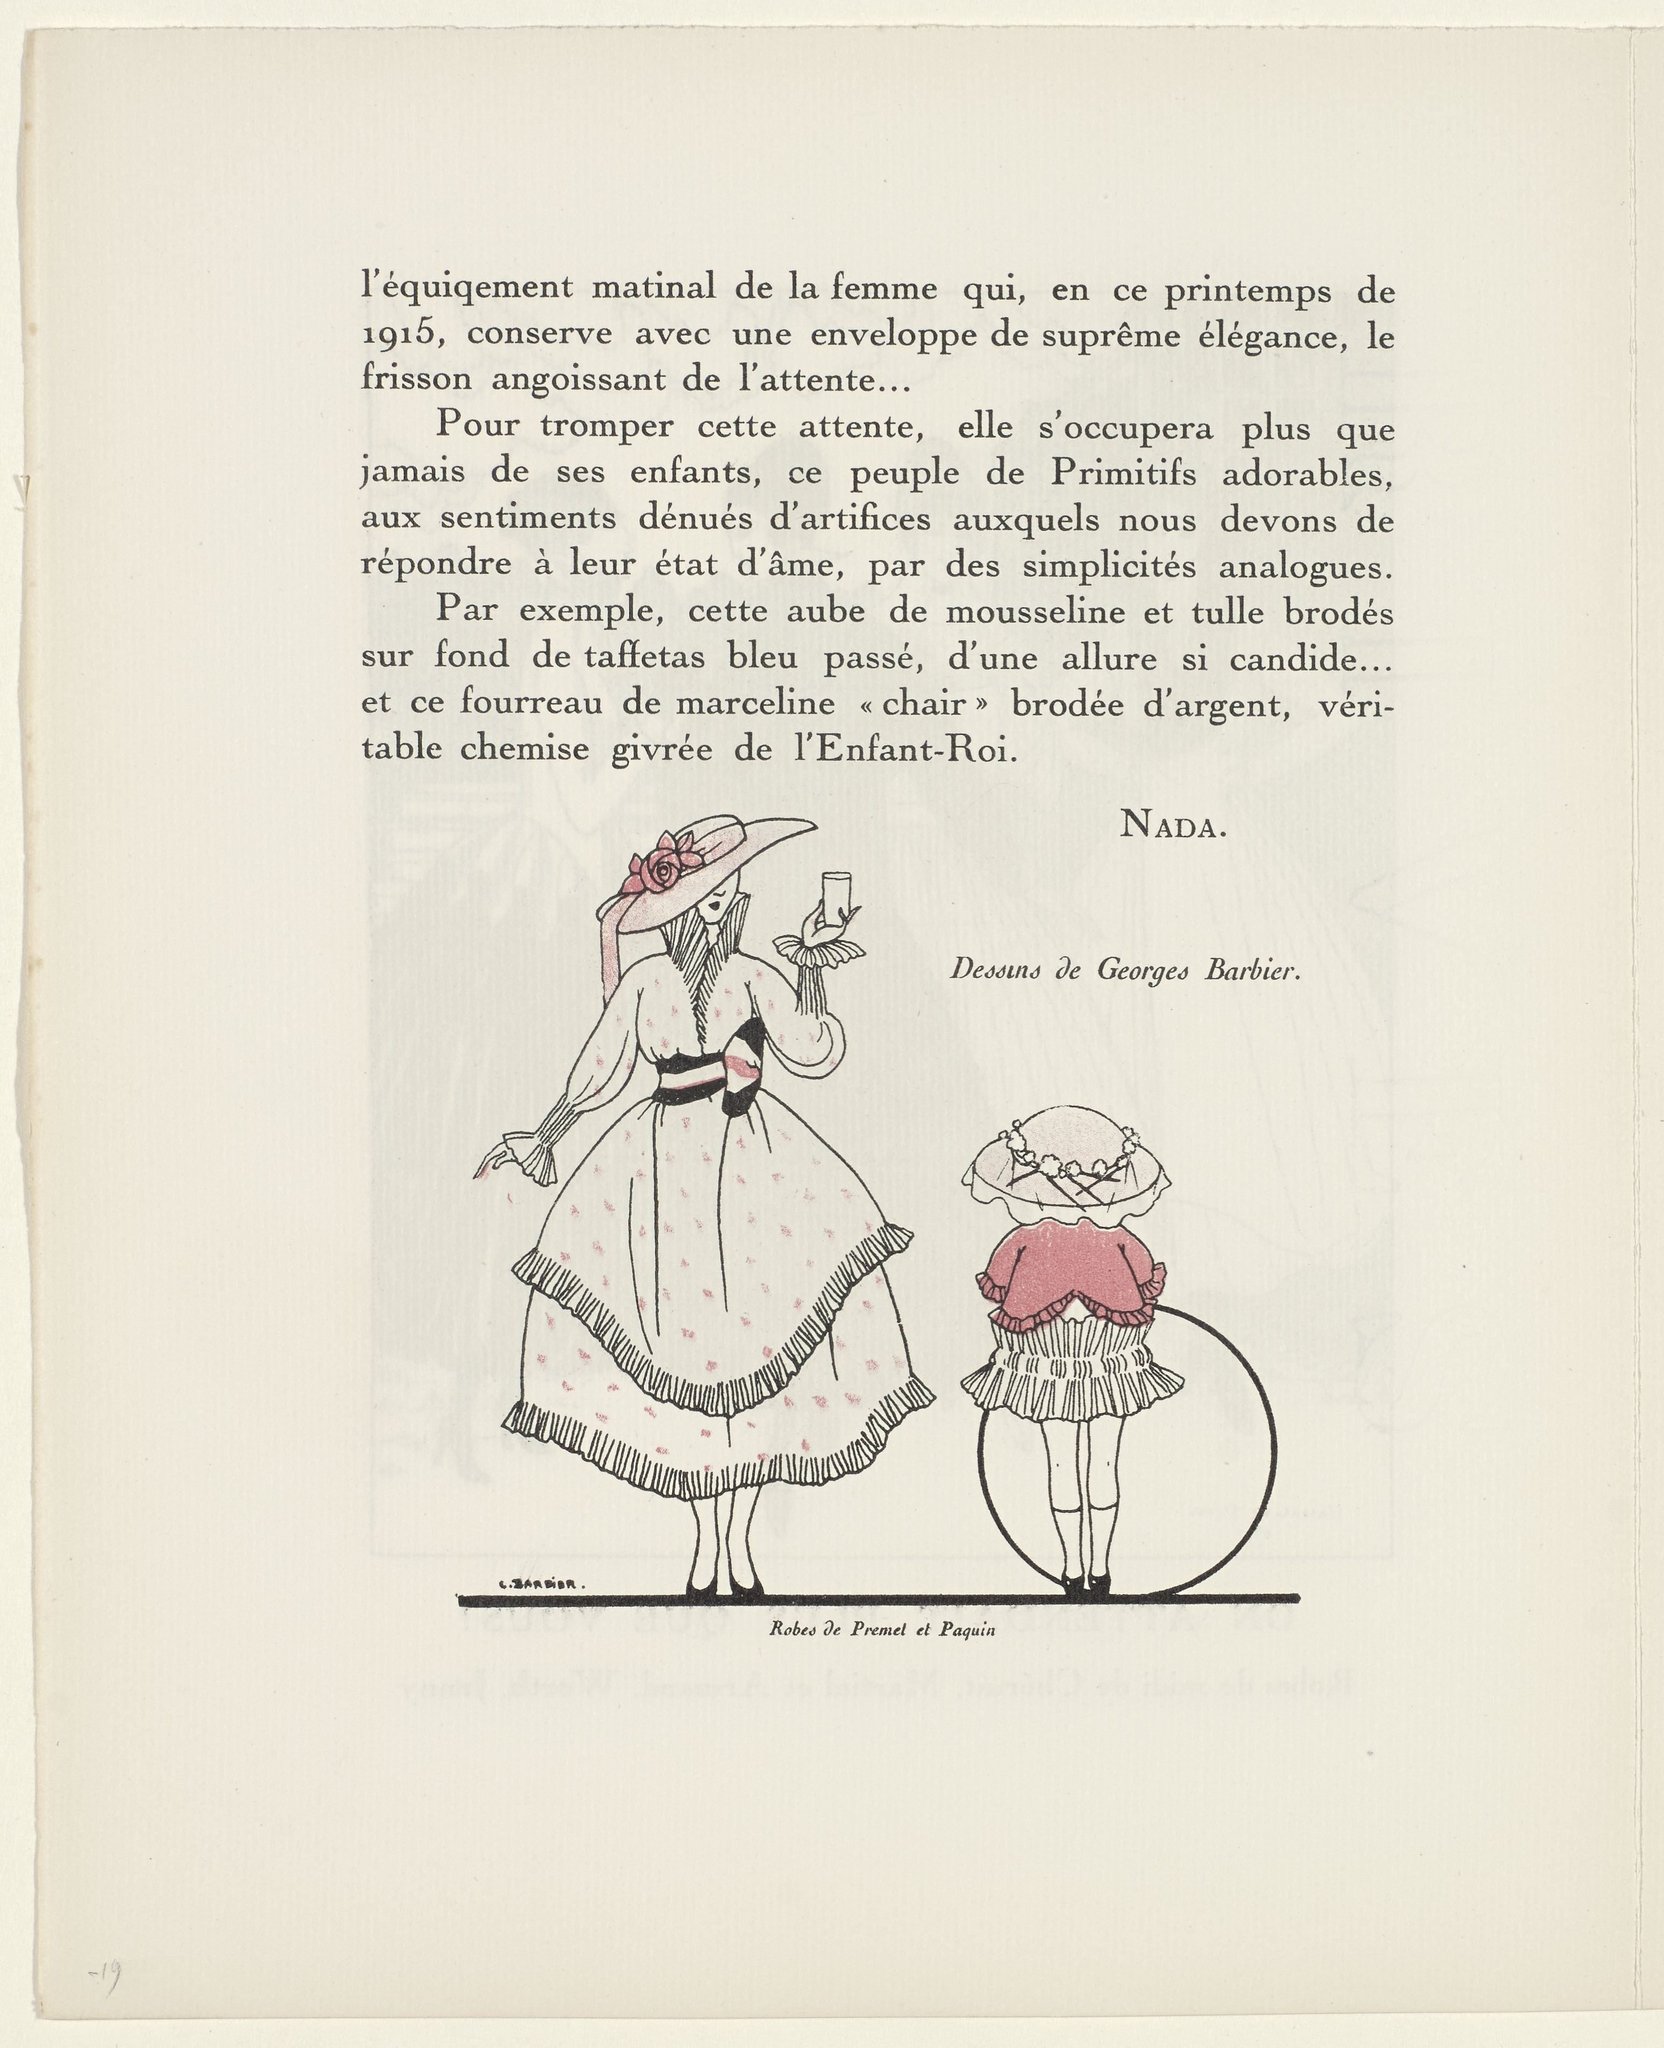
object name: fashion print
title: Gazette du Bon Ton, 1915 - No. 8-9, p. 26: Atours simples: Robes de Premet et Paquin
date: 1915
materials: paper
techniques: photochemical processes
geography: london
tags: fashion plates, head-gear: hat (+ women's clothes), dress, gown (+ women's clothes), dress, gown (+ girls' clothes)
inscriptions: date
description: Gazette du Bon Ton 1915, No. 8-9, p. 26: tekst en illustratie: vrouw en kind met hoepel: Robes de Premet et Paquin